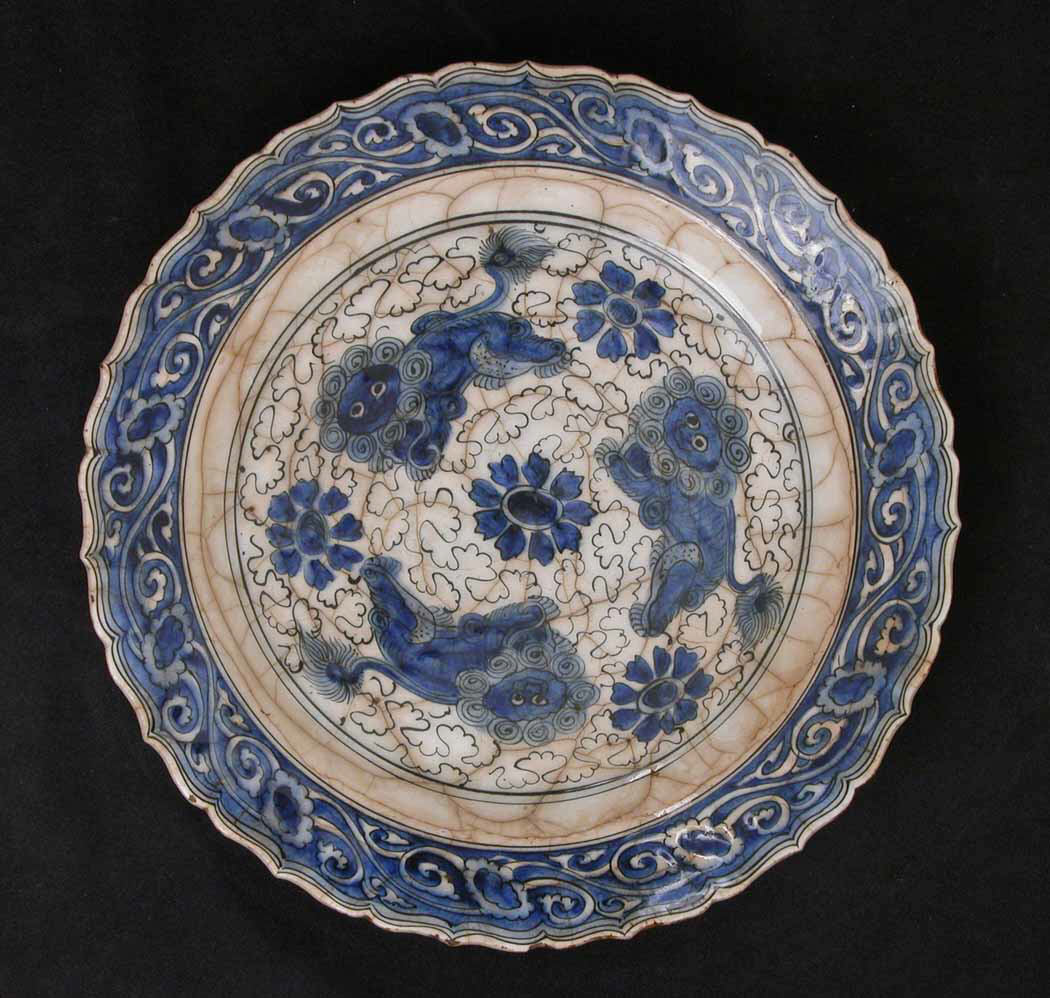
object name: dish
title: Dish with Three Lions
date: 1701-1800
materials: glaze, stonepaste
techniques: painting, polychrome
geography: iran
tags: lions